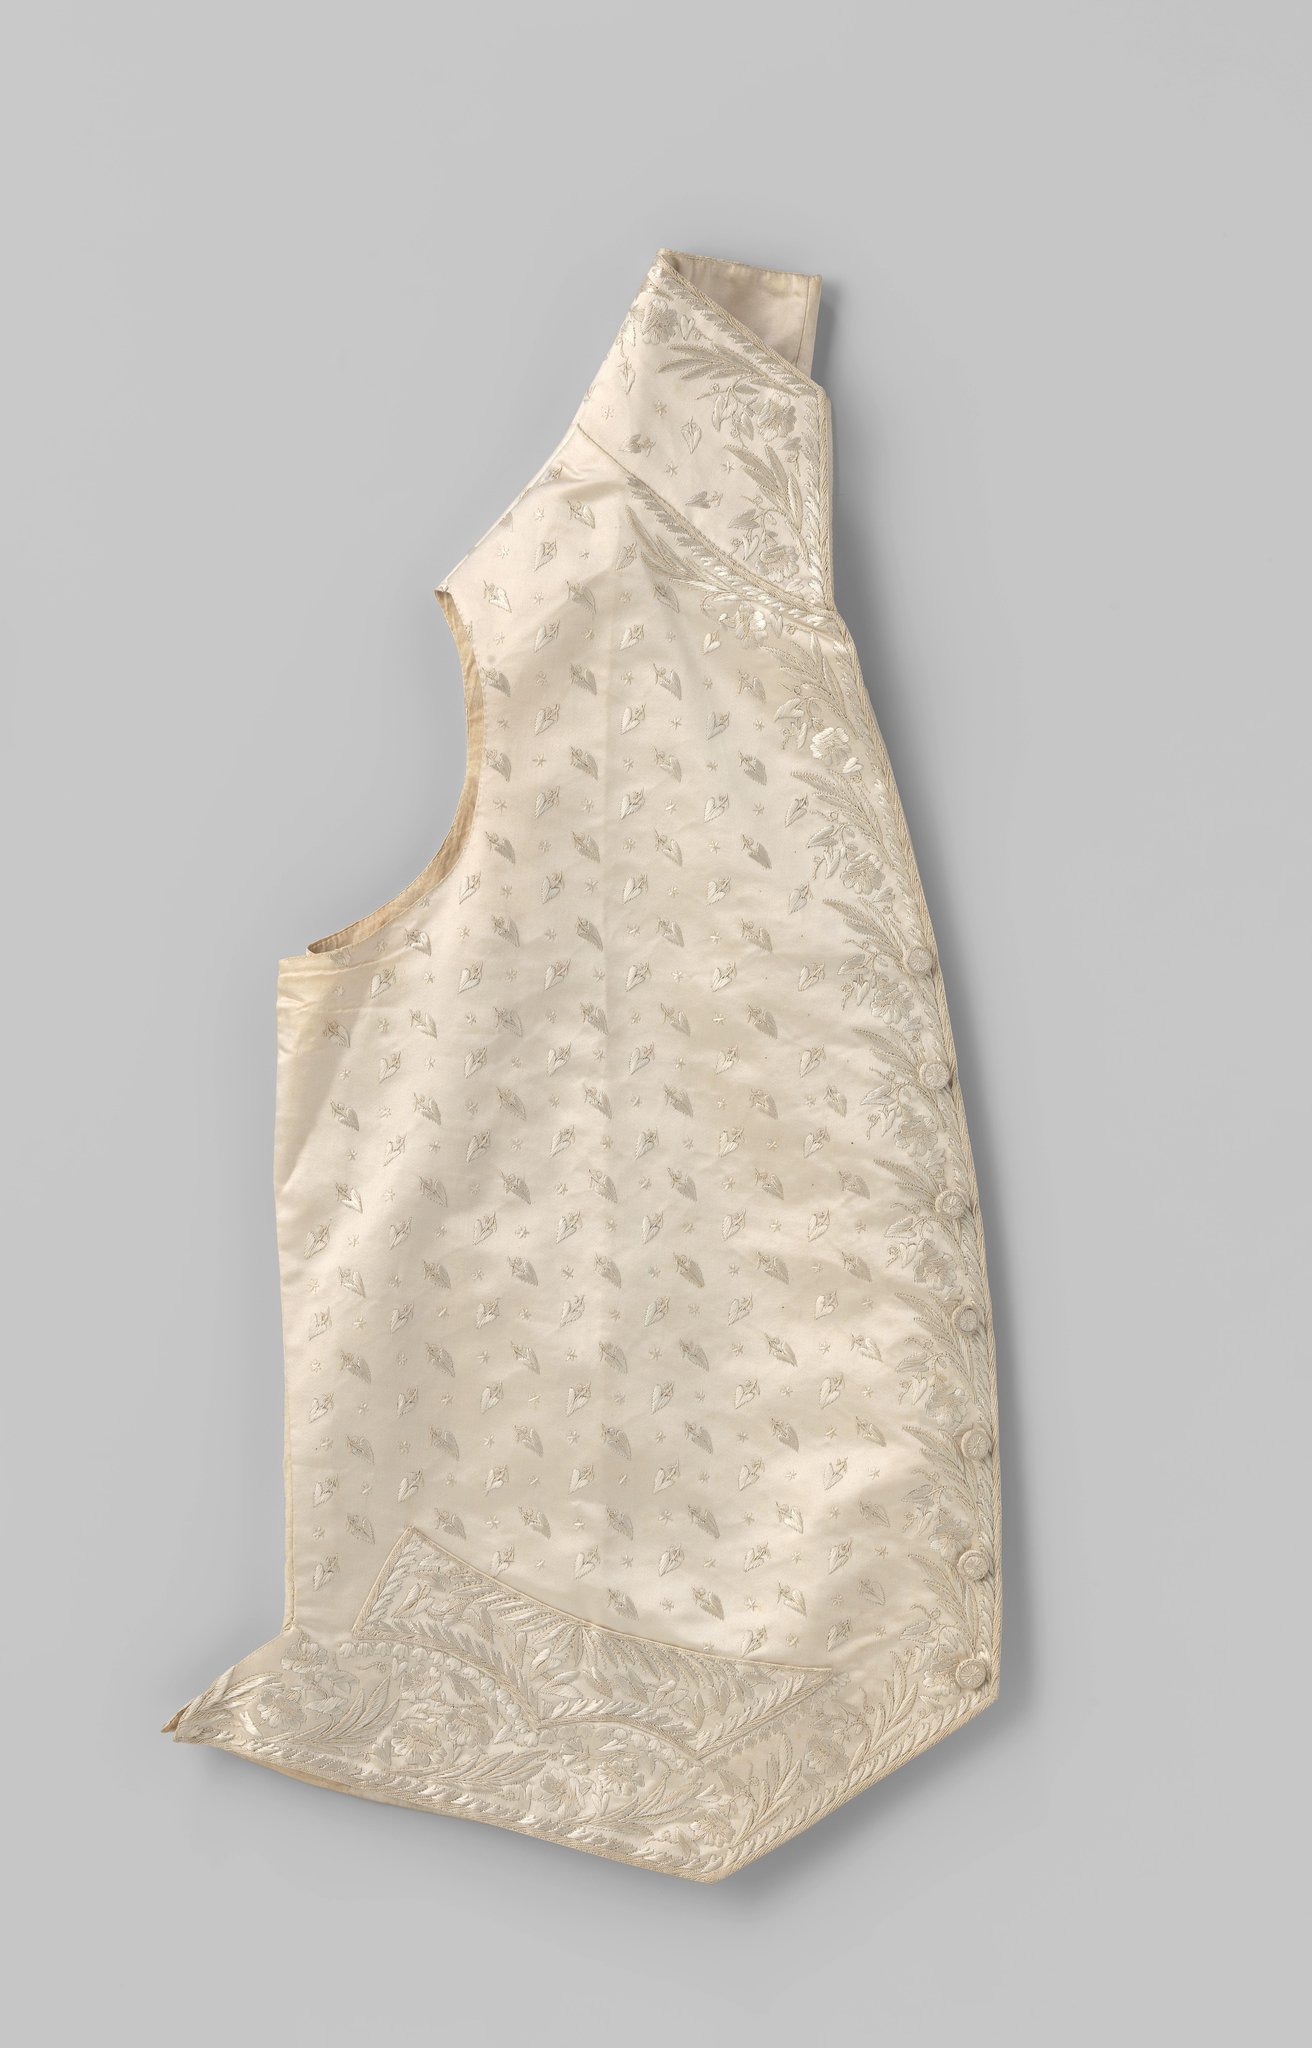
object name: main garment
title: Vest van cremekleurige satijn met hoge opstaande boord, schuin weggesneden voorpanden en opgenaaide zakkleppen, versierd met blad- en bloemmotieven geborduurd in cremekleurige zijde.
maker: Anonymous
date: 1800-1825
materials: linen, silk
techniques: embroidered, weave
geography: netherlands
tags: directeur, bartholomeus gerardus cornelis van haeften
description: Vest van cremekleurige satijn met hoge opstaande boord, schuin weggesneden voorpanden en opgenaaide zakkleppen, versierd met blad- en bloemmotieven geborduurd in cremekleurige zijde. Model: sluiting middenvoor door middel van zeven geborduurde knoopjes van hetzelfde satijn. Eerste knoop op 14,5 cm onder de halslijn. Valse zakkleppen geheel opgenaaid. Rugpand van linnen met vetersluiting. Linnen voering met langs de voorpanden en in de boord satijnen beleg. Boord opgebouwd uit drie delen: twee geborduurde aan weerskanten met een ongeborduurde middenachter. Versiering: langs de voorpanden een rand met diagonaal geplaatste hartvormige bladeren. Hiernaast een 3,5 cm brede rand van blad- en bloemmotieven. Zakkleppen ook geheel versierd met florale motieven. Verder een strooimotief van hartvormige bladeren waartussen (afgewisseld met) sterretjes. Voor het borduurwerk zijn de steel-, ingrijp- en knoopjessteek gebruikt. Op de knoopjes een sterretje binnen een cirkel. Op het beleg van het rechter voorpand bovenaan (waar geen knopen zijn en het dus openvalt) drie vergelijkbare cirkels waarbinnen een ster is geborduurd, die de illusie van knoopjes moeten wekken?!